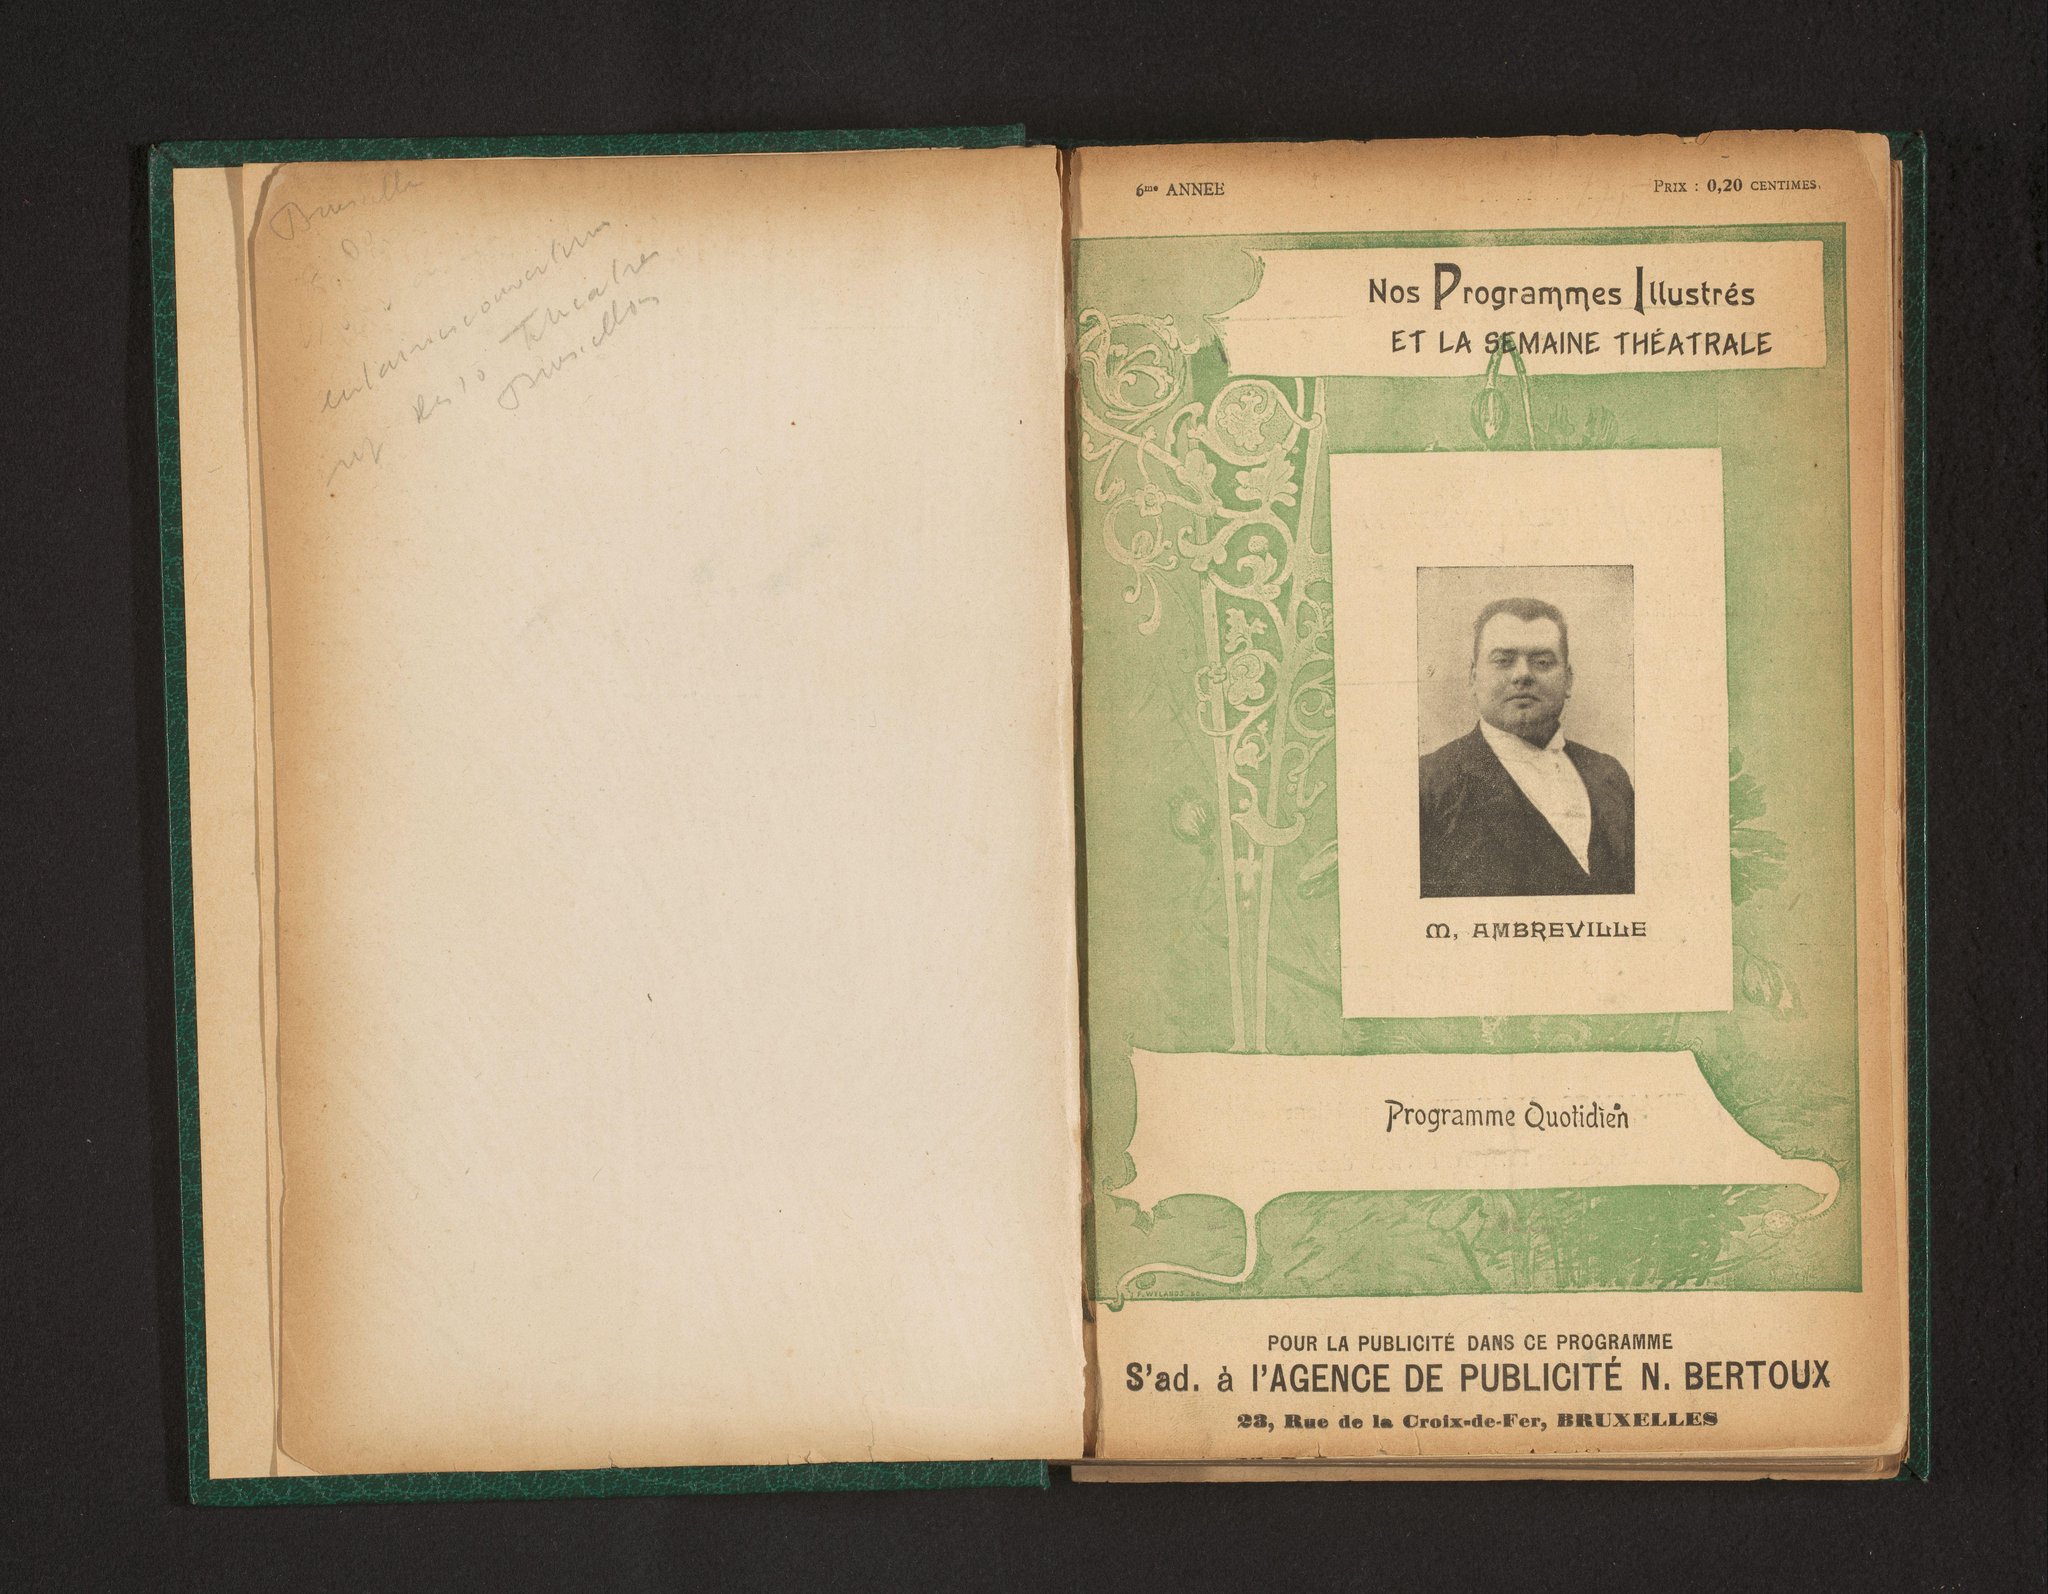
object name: photomechanical print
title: Portret van M. Ambreville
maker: Anonymous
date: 1895-1900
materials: paper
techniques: autotype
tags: brussels, adult man, historical persons